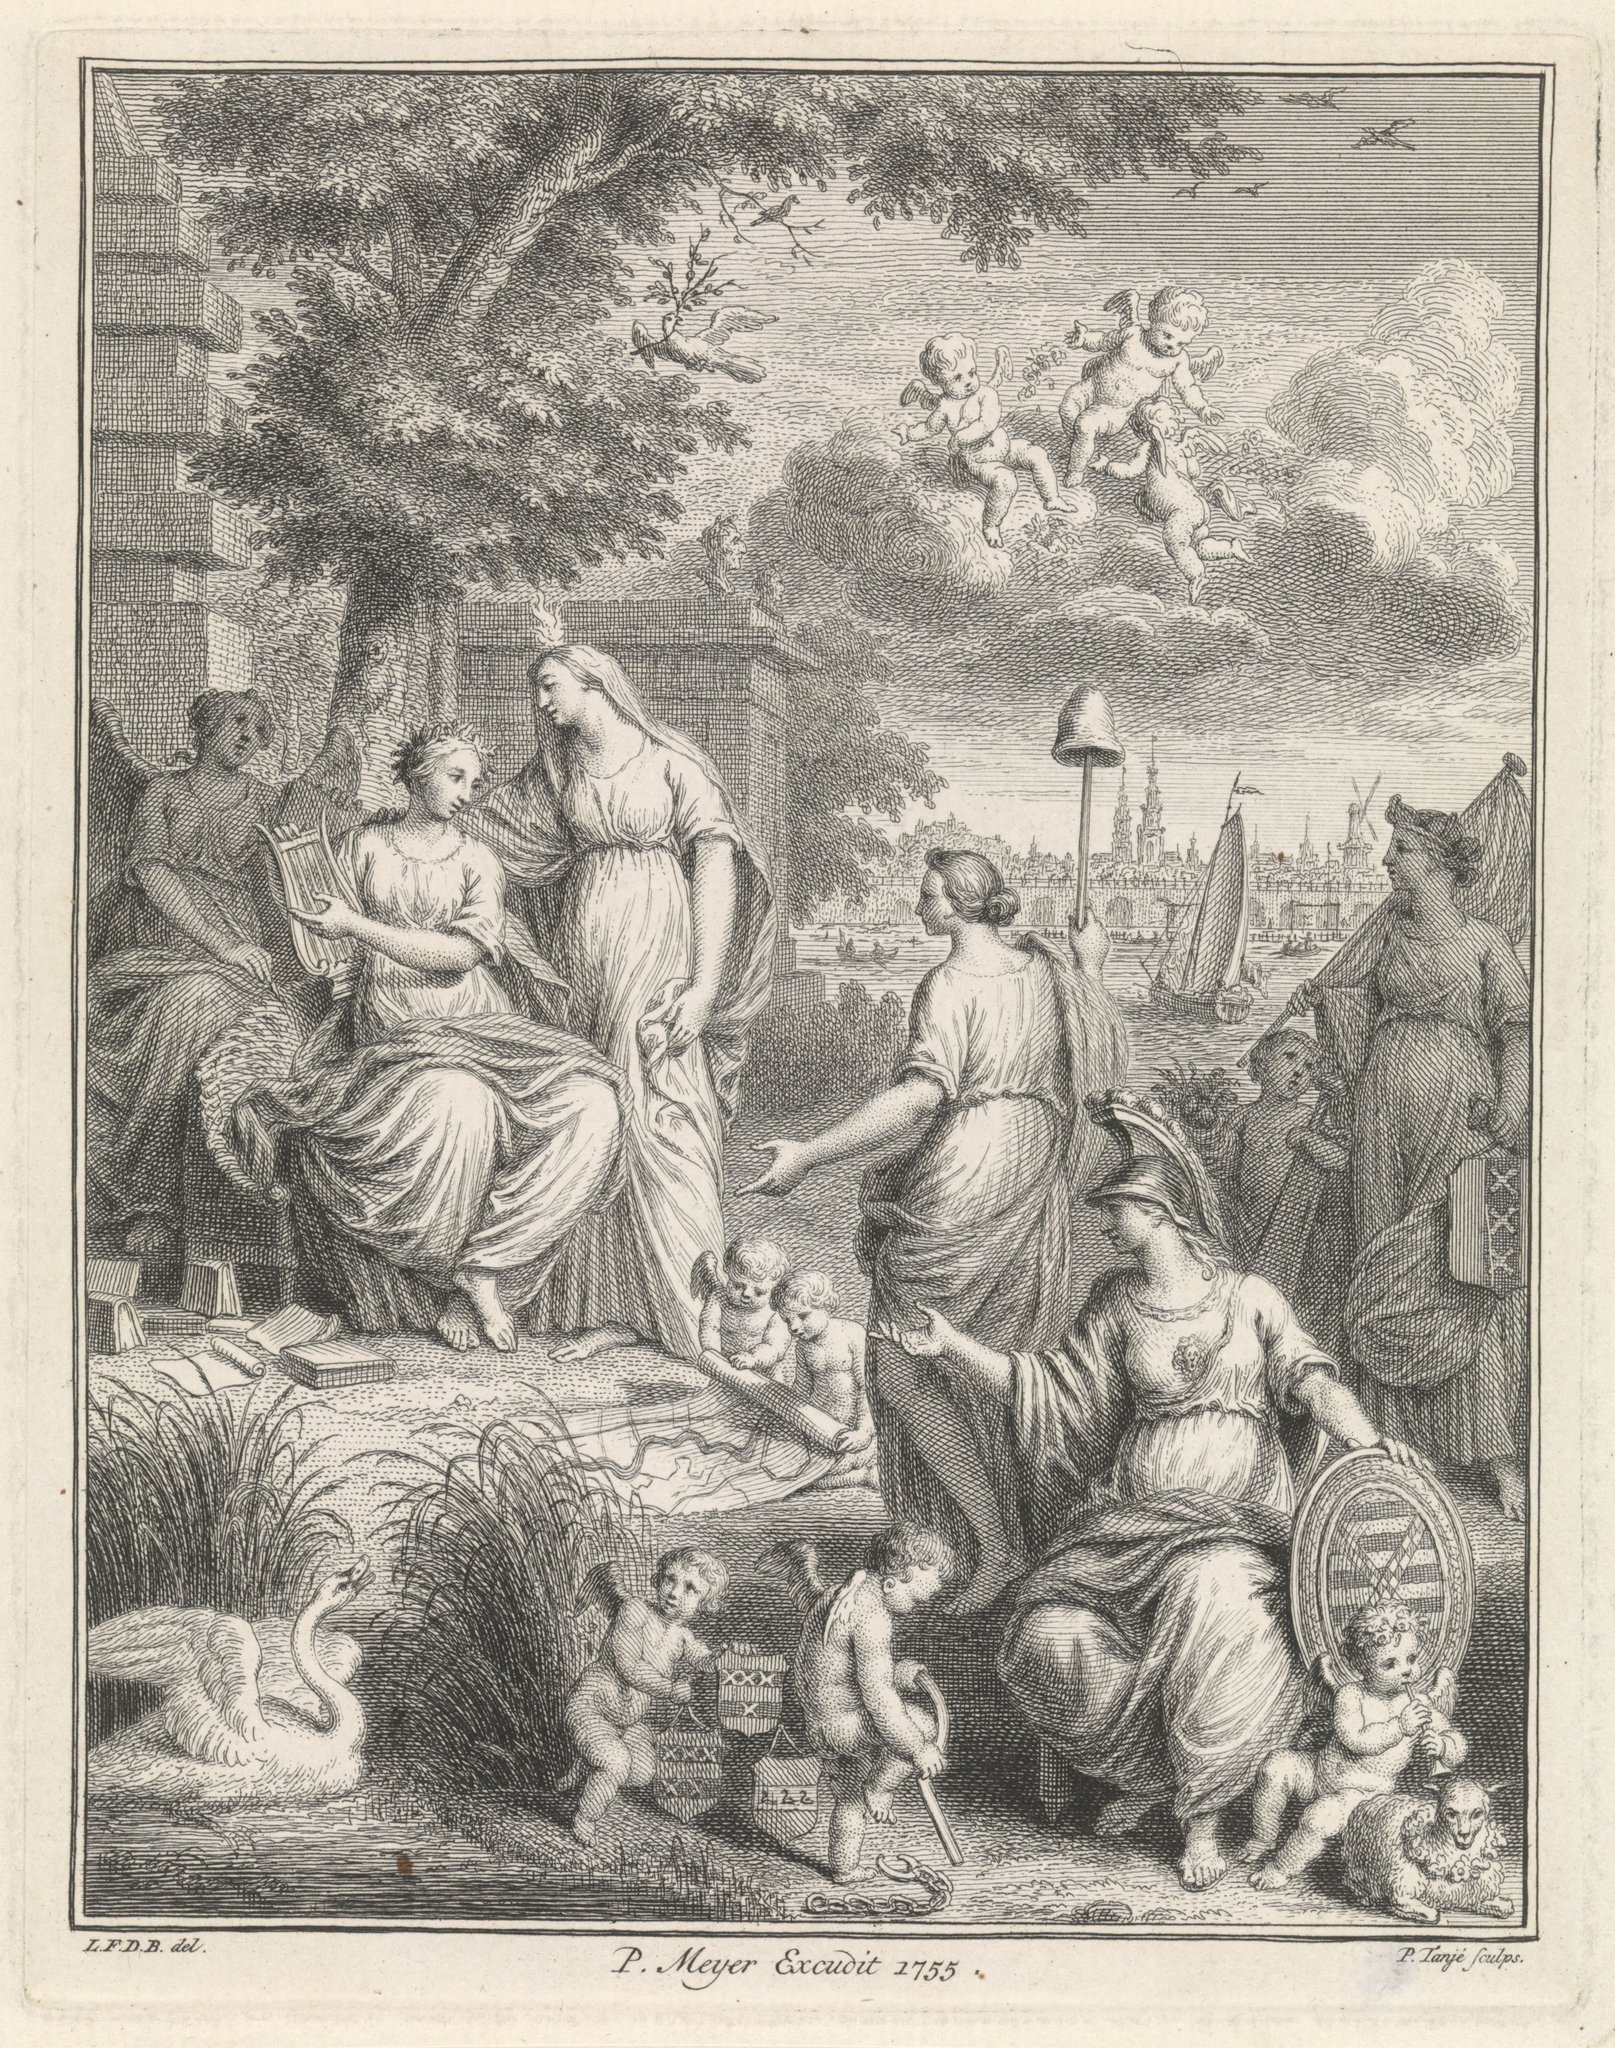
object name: print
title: Dichtkunst en Vrijheid en de rivier de Amstel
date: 1755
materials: paper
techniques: engraving, etching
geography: amsterdam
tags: river, symbolic representations, allegories and emblems ~ poetry; 'poesia' (ripa), freedom, liberty; 'libertà' (ripa)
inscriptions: collector's mark: Lugt 2228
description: De Vrijheid, met een vrijheidslans, presenteert zich aan de Dichtkunst. Dichtkunst houdt een lier in de handen en wordt bijgestaan door Geschiedenis, met pen, en Godsdienst, die de vlam van goddelijke inspiratie op haar hoofd heeft. Minerva zit op de voorgrond. Putti tonen een kaart met de stroom van de rivier de Amstel. Op de voorgrond tonen putti de wapenschilden van dorpen aan de Amstel. Op de achtergrond de stad Amsterdam met het IJ. Titelpagina voor een boek met gedichten over de rivier de Amstel.